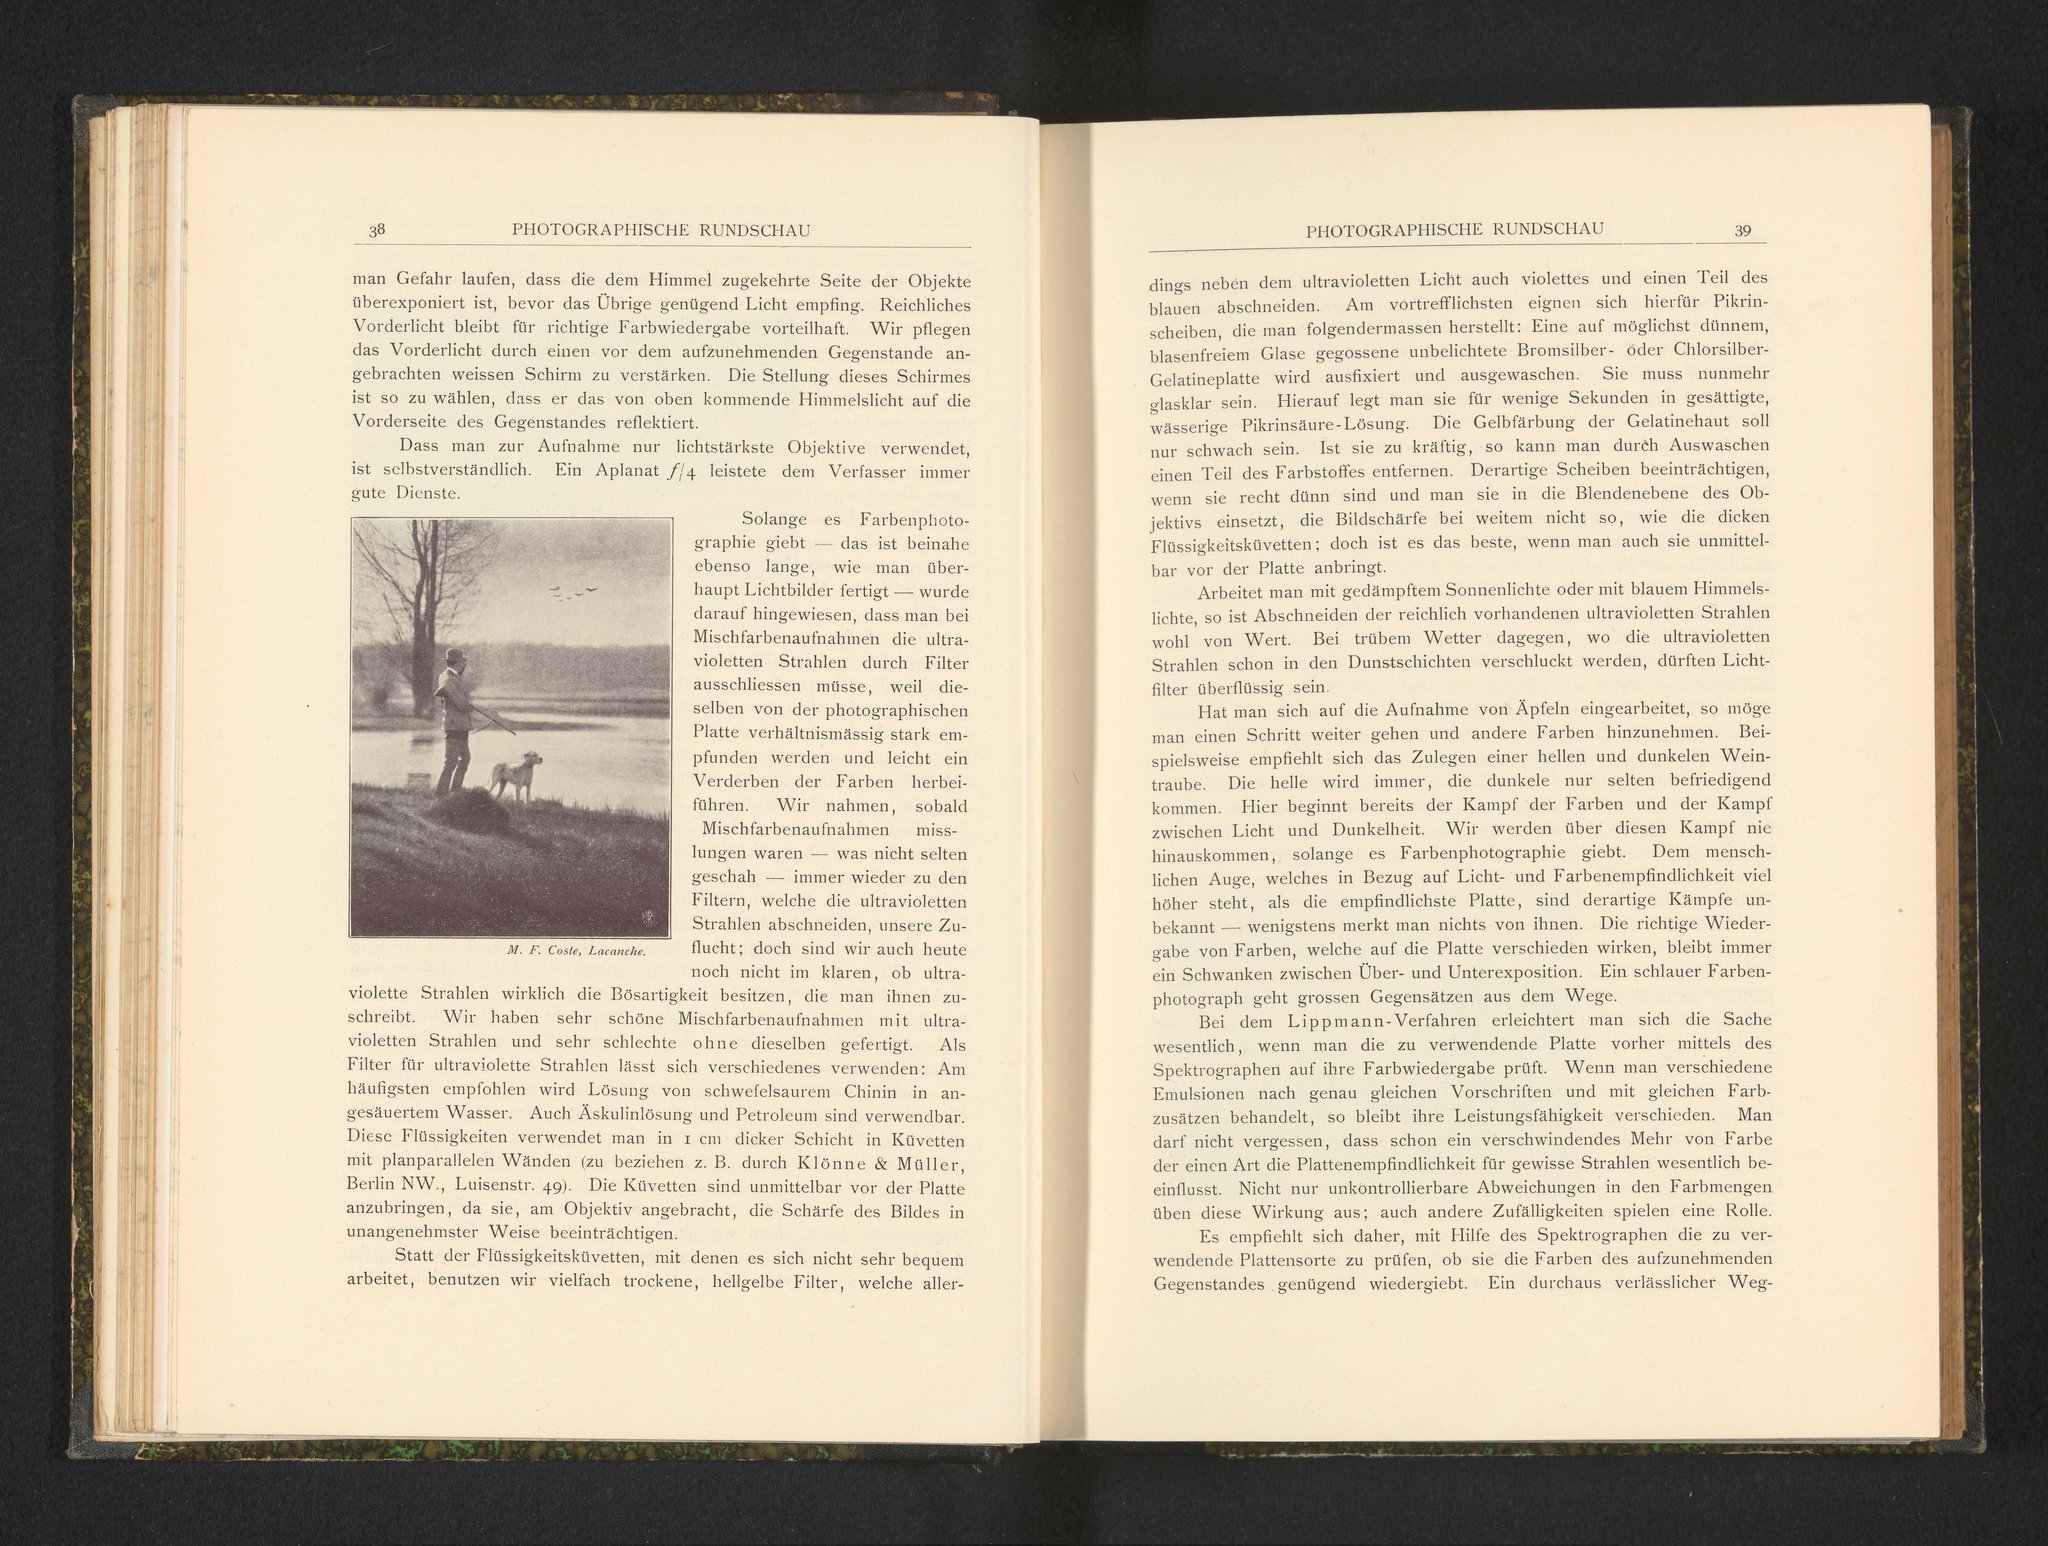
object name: photomechanical print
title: Jager met een jachthond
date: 1893-1898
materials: paper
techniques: autotype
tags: hunting dogs, hunter